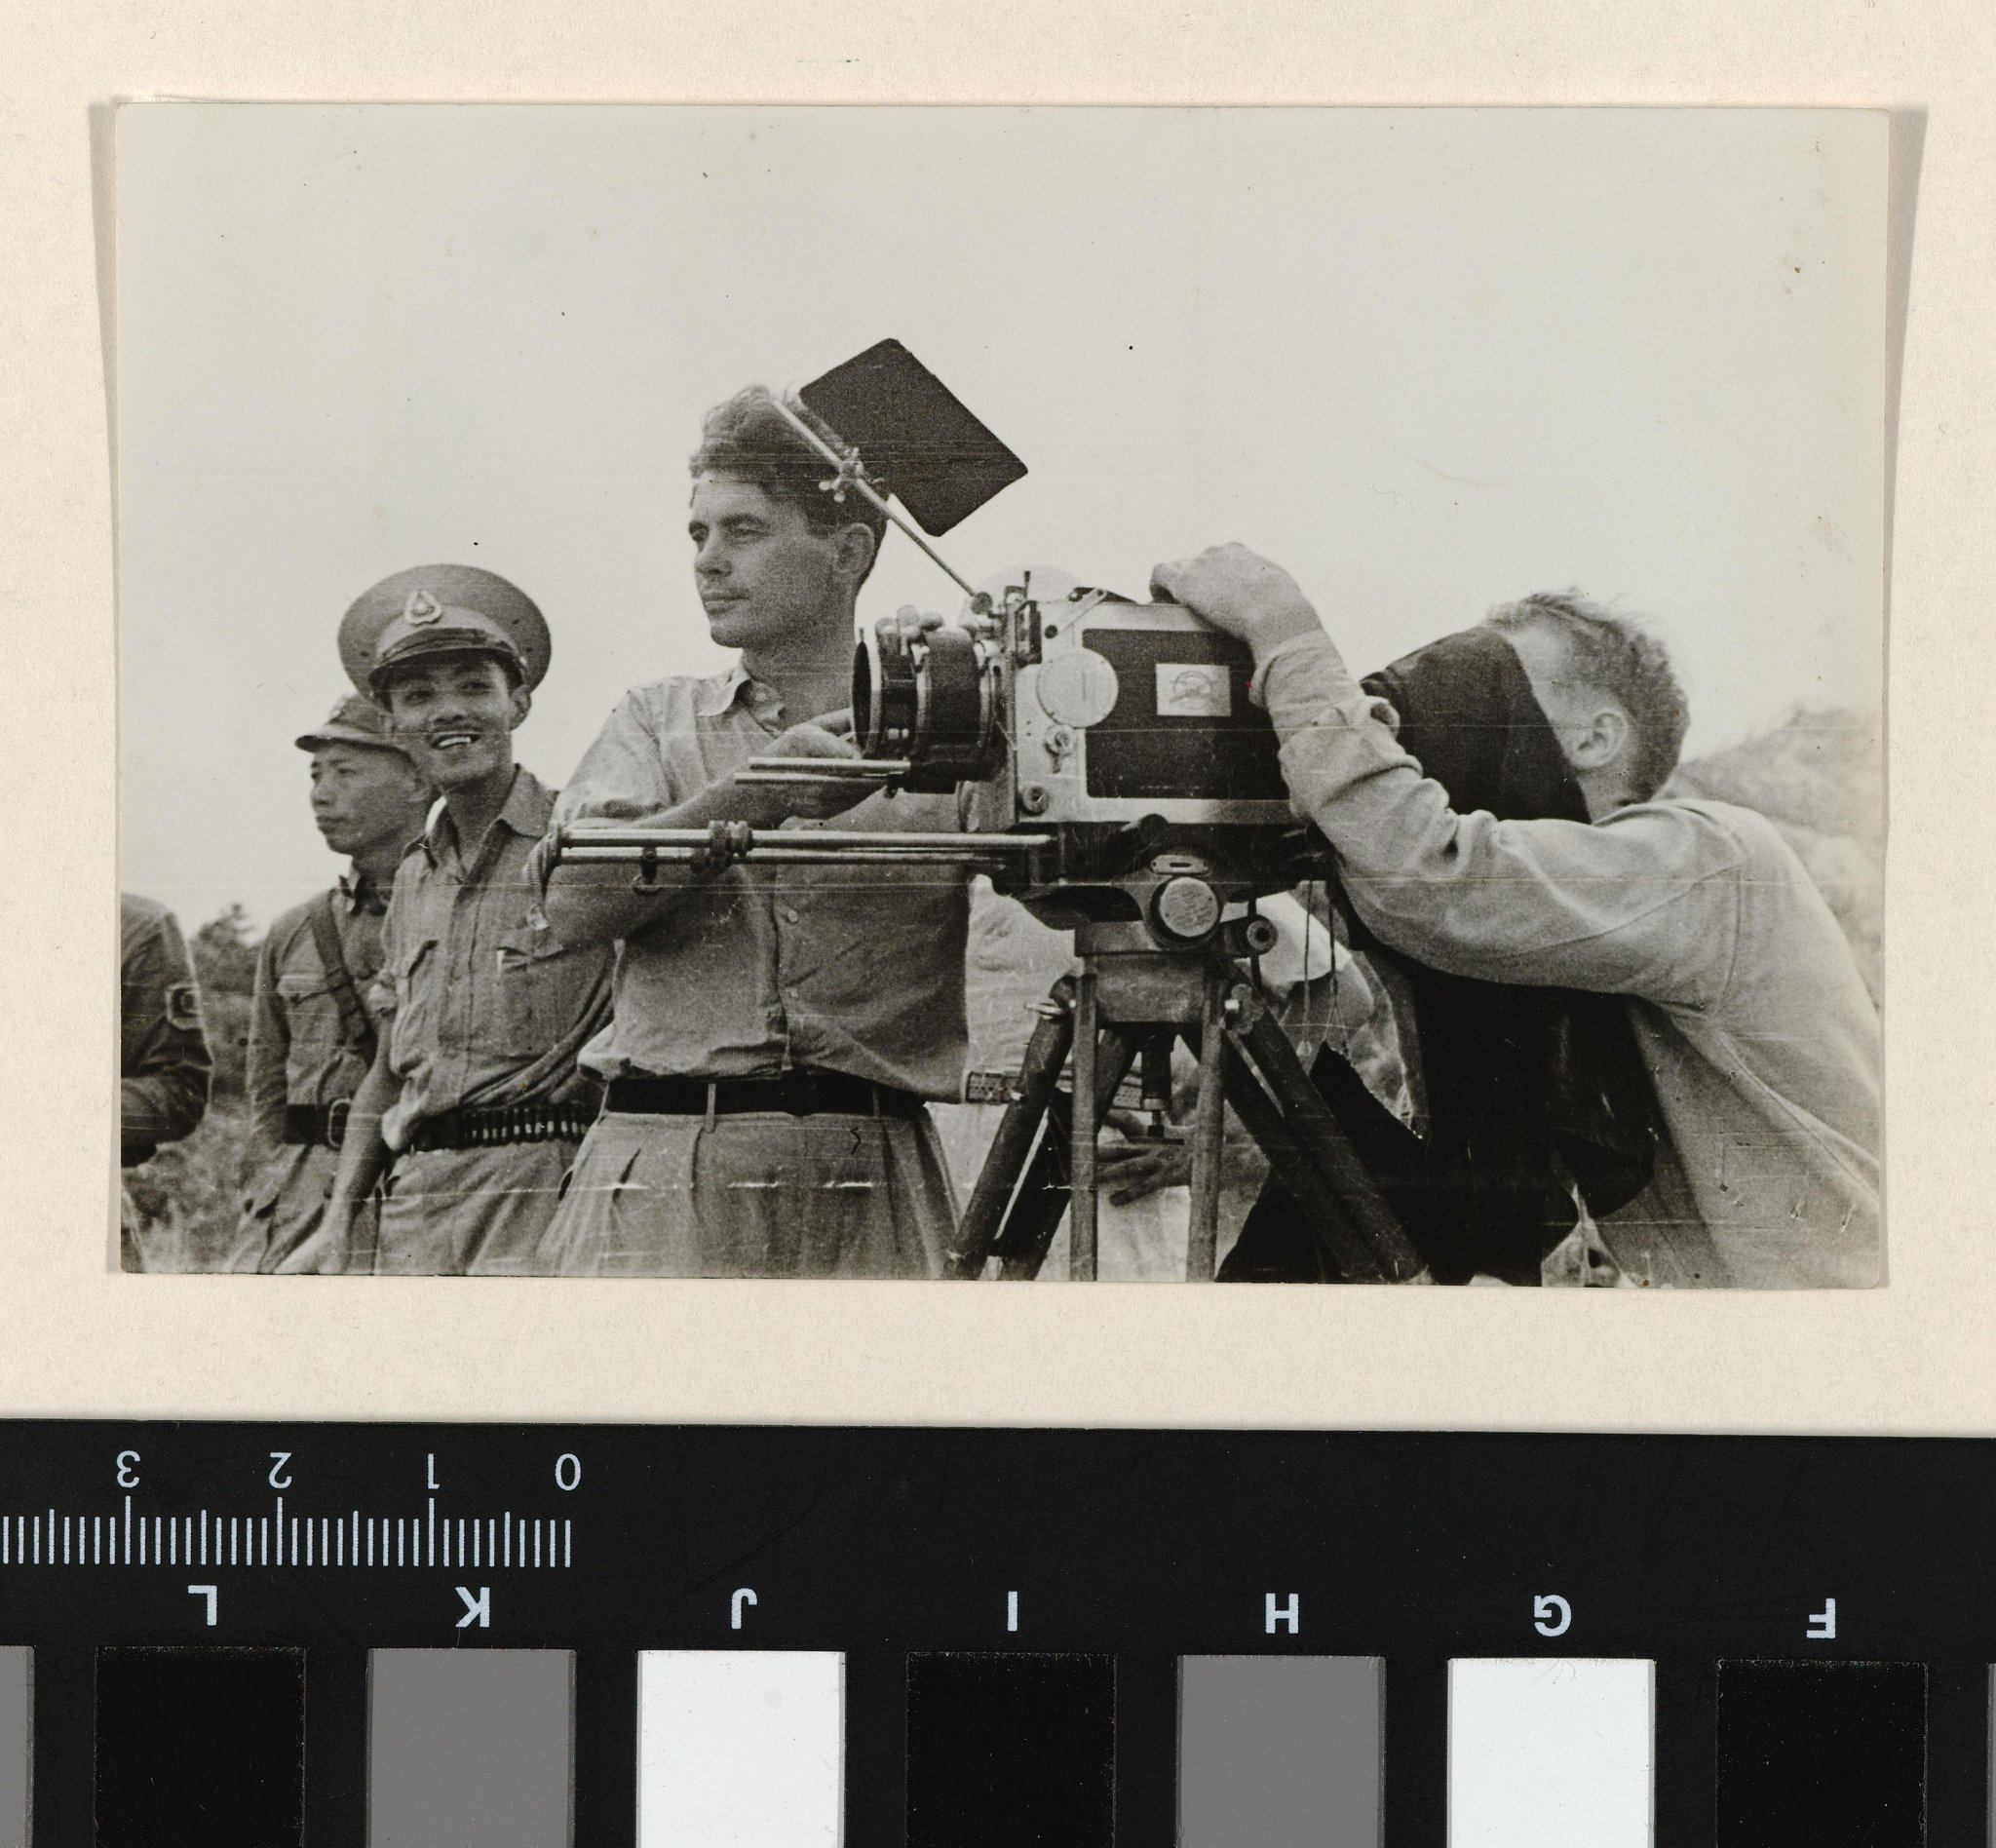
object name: photograph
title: John Fernhout en Joris Ivens achter de camera, China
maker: robert capa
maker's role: fotograaf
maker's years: 1913-1954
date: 1938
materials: paper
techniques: gelatin silver print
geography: china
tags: john fernhout, nijmegen, paris, joris ivens, filming, cinematographer at work - cc - out of doors, china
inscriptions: stamp: ‘K 295’